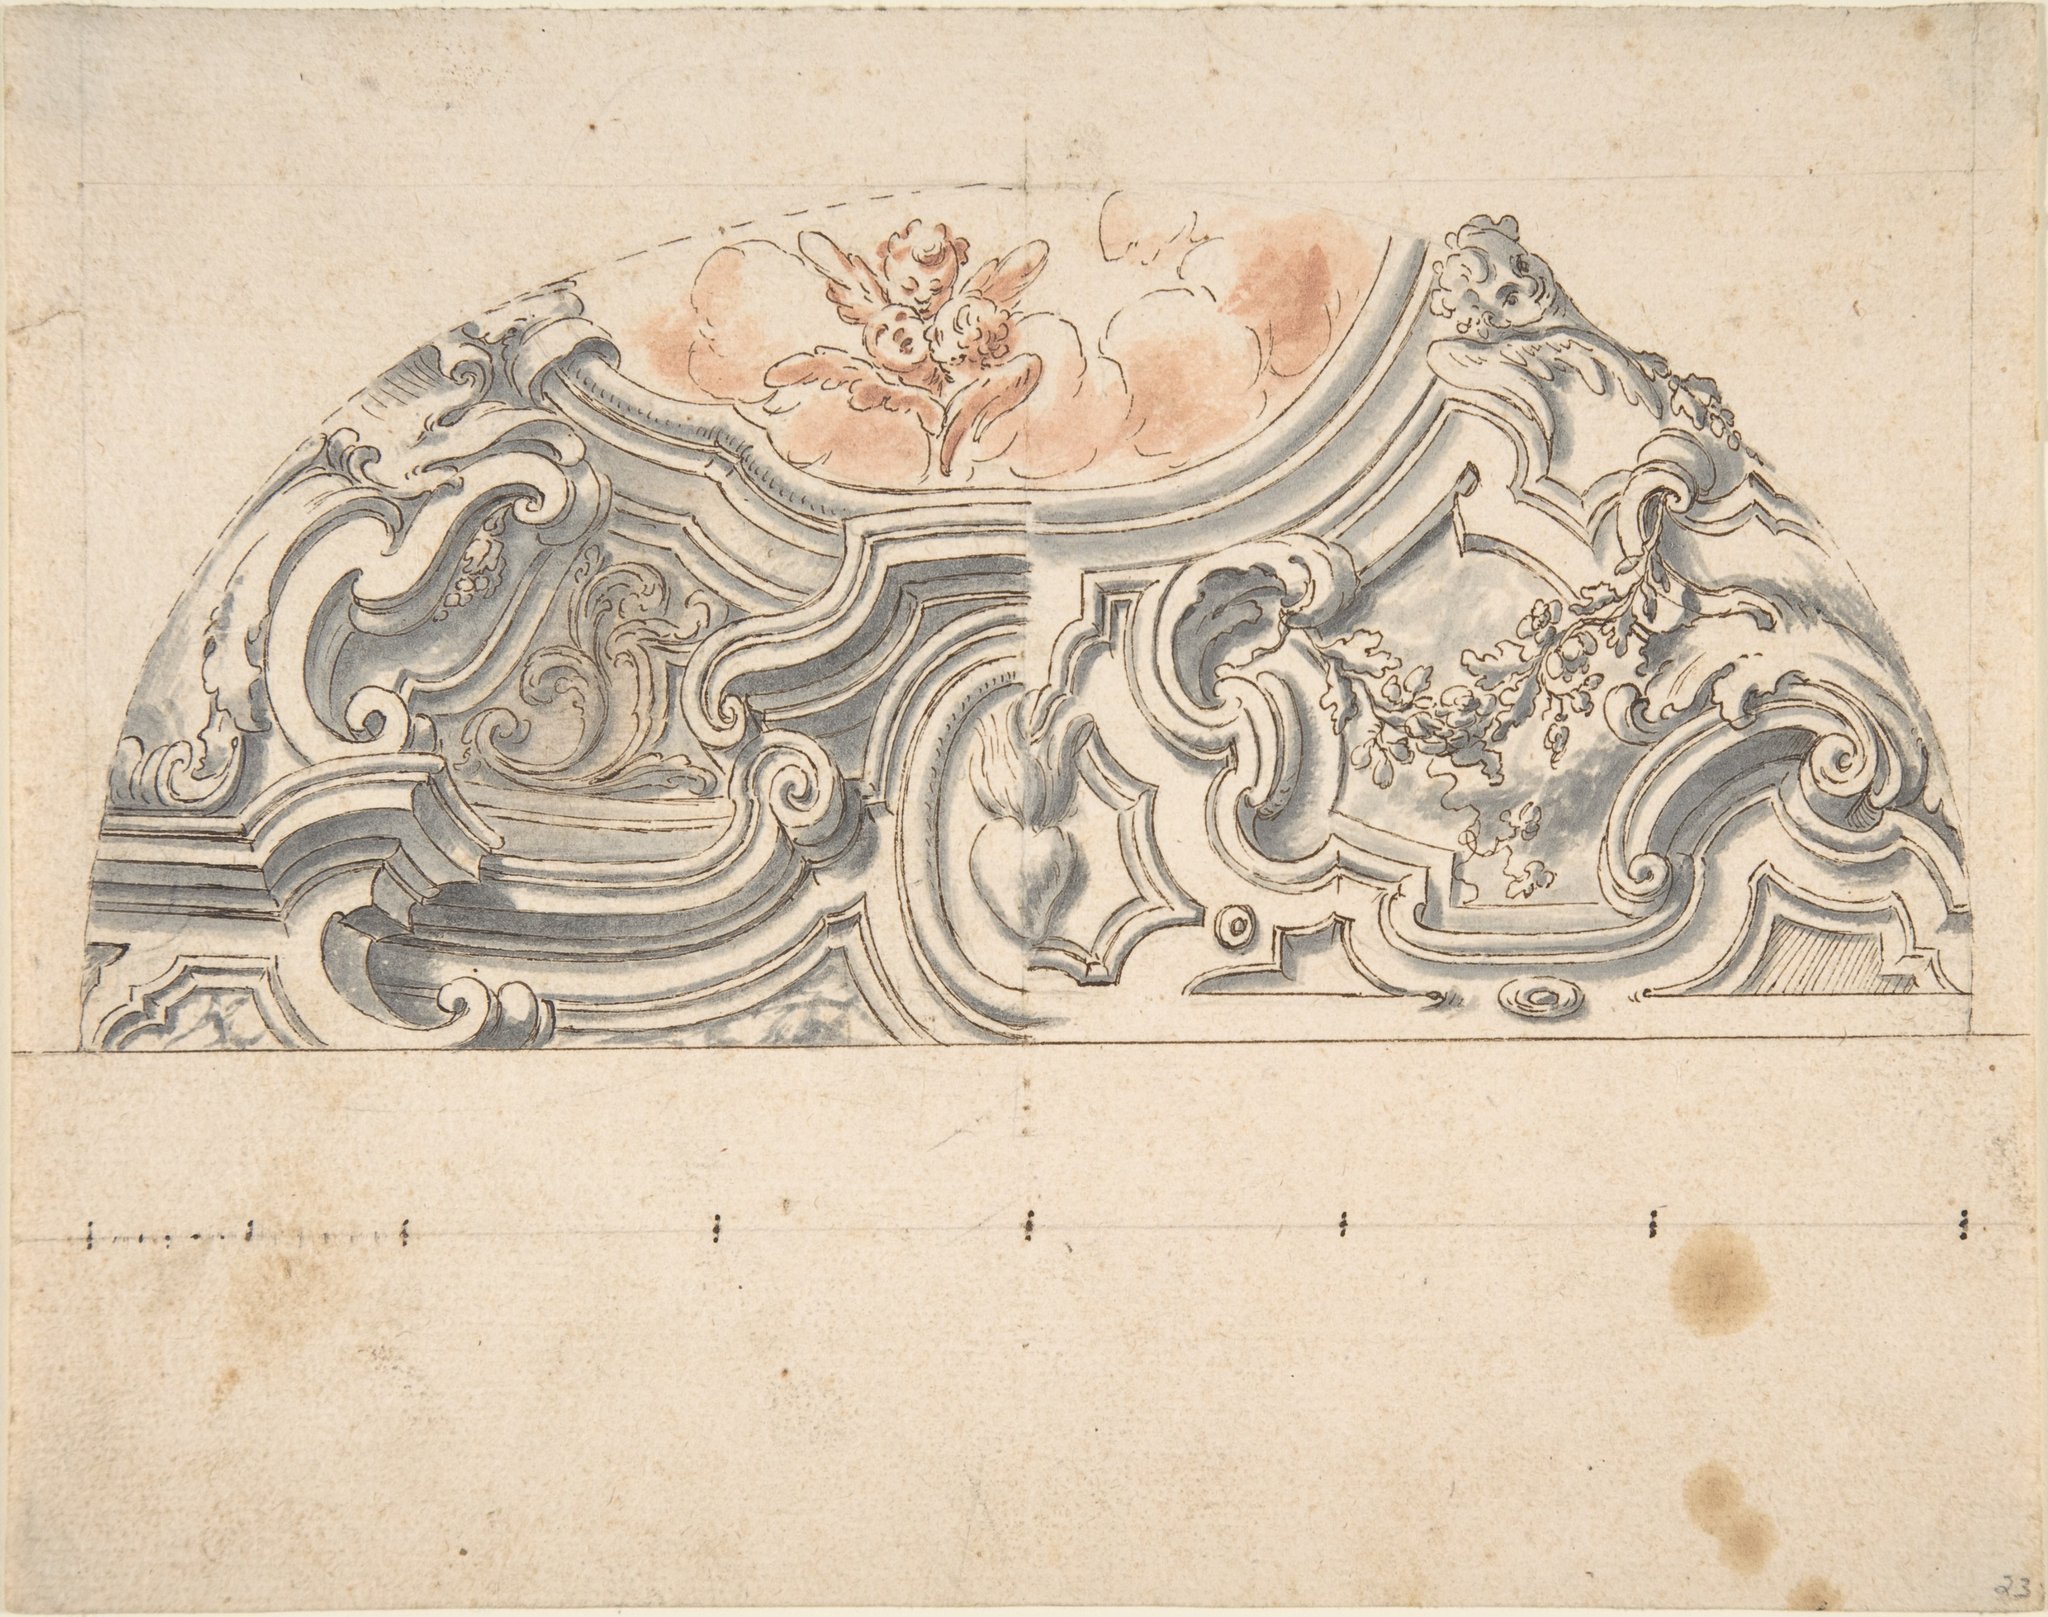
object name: drawing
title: Two alternate designs for stucco for an Italian ceiling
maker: anonymous, italian, piedmontese, 18th century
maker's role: artist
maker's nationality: italian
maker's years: 1700-1800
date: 1700-1780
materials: chalk, graphite, ink, drawing material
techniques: brush, drawing, pen, wash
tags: heads,leaves